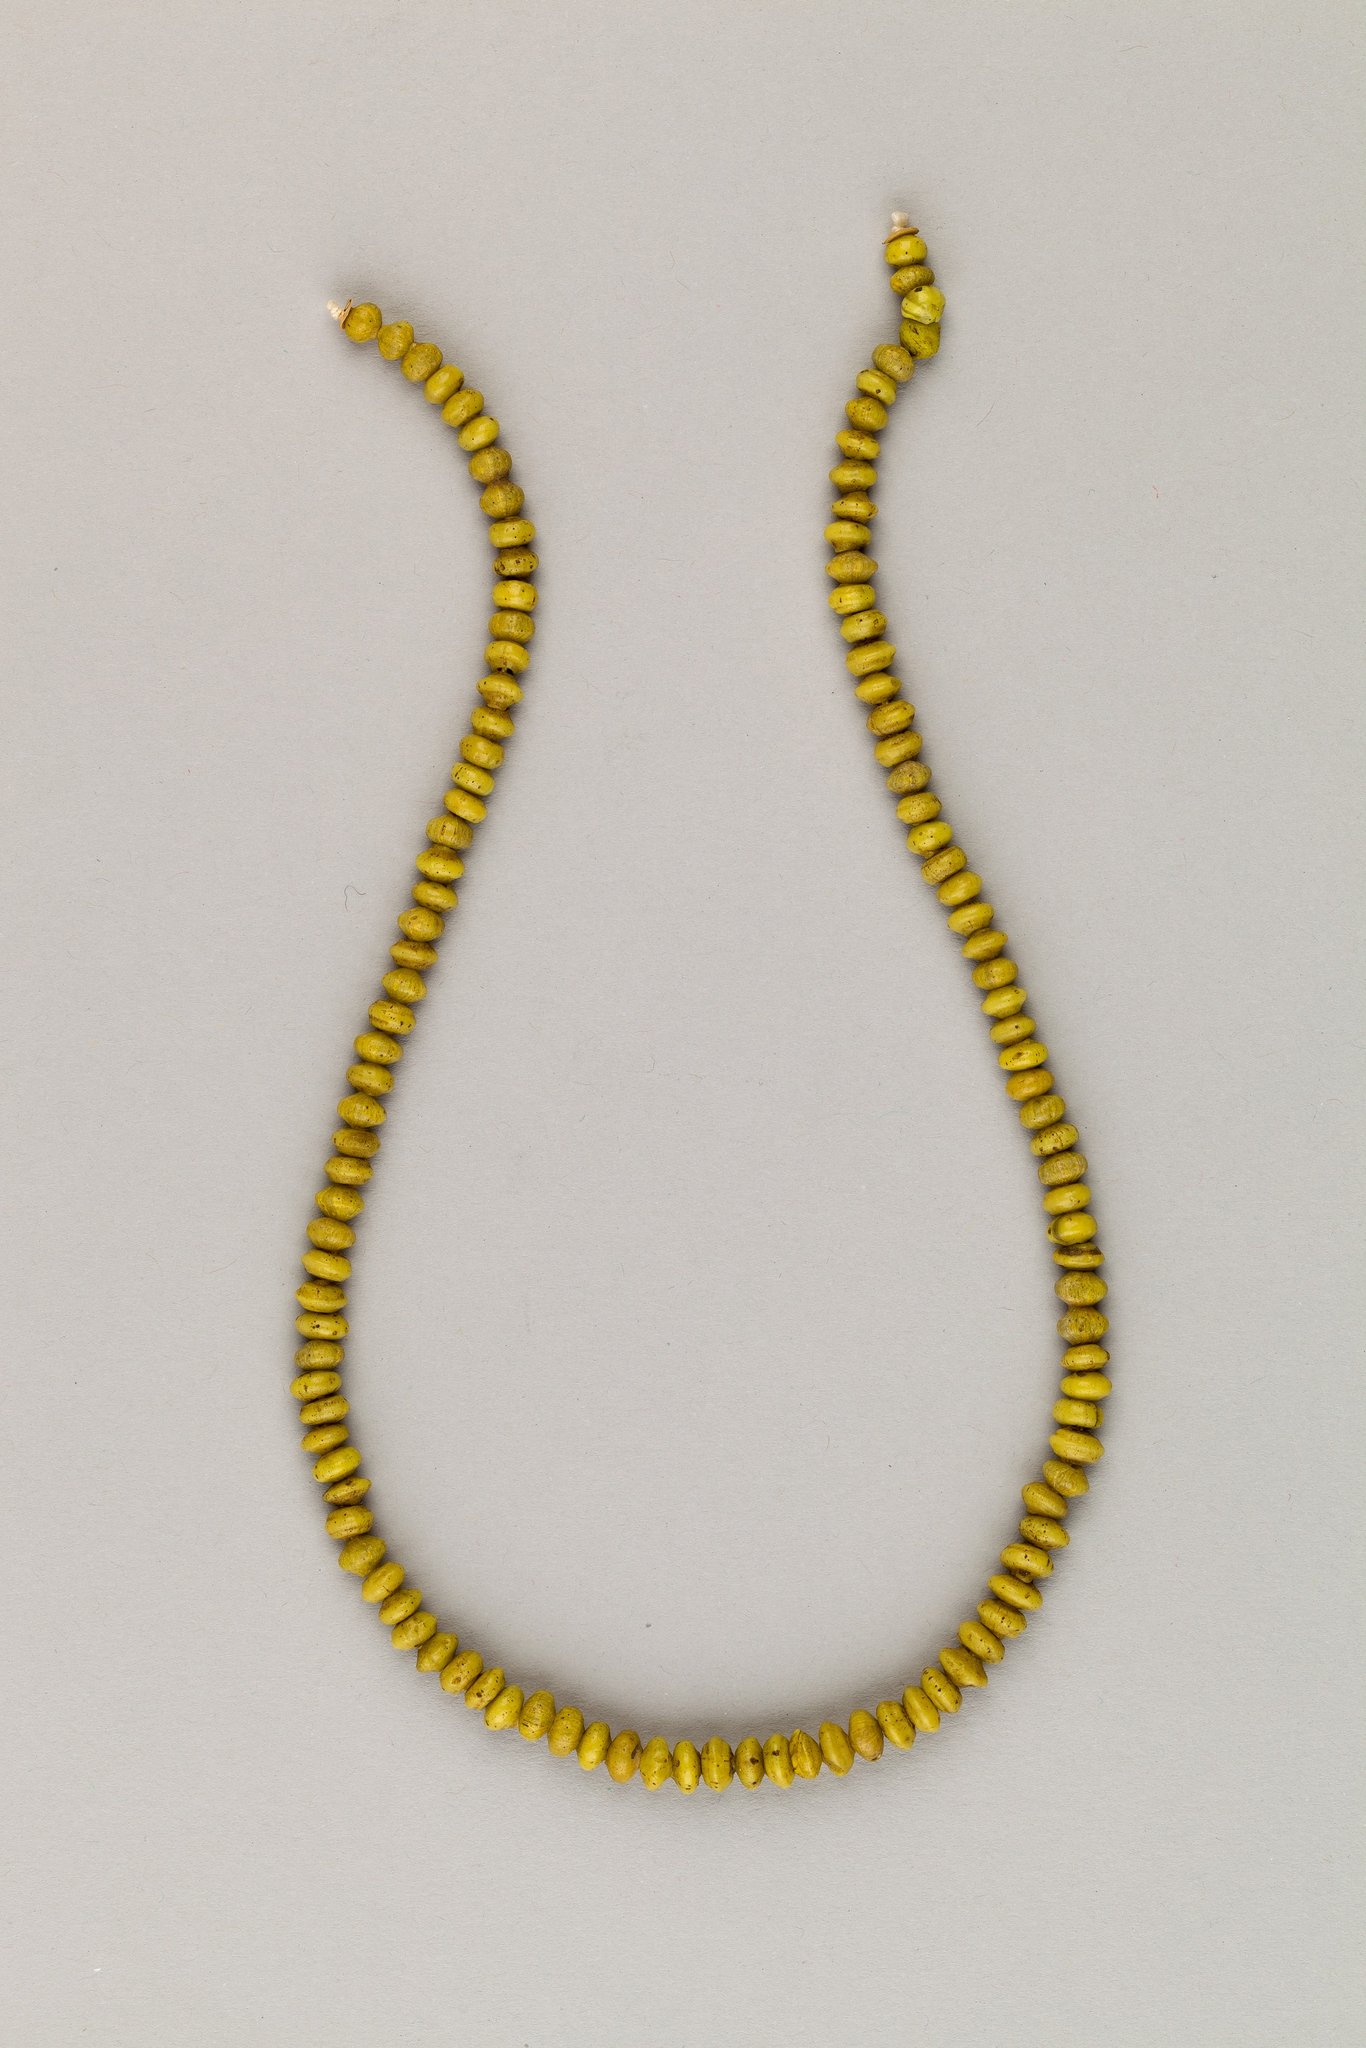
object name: bead, string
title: String of 115 discoid ridged beads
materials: glass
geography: egypt